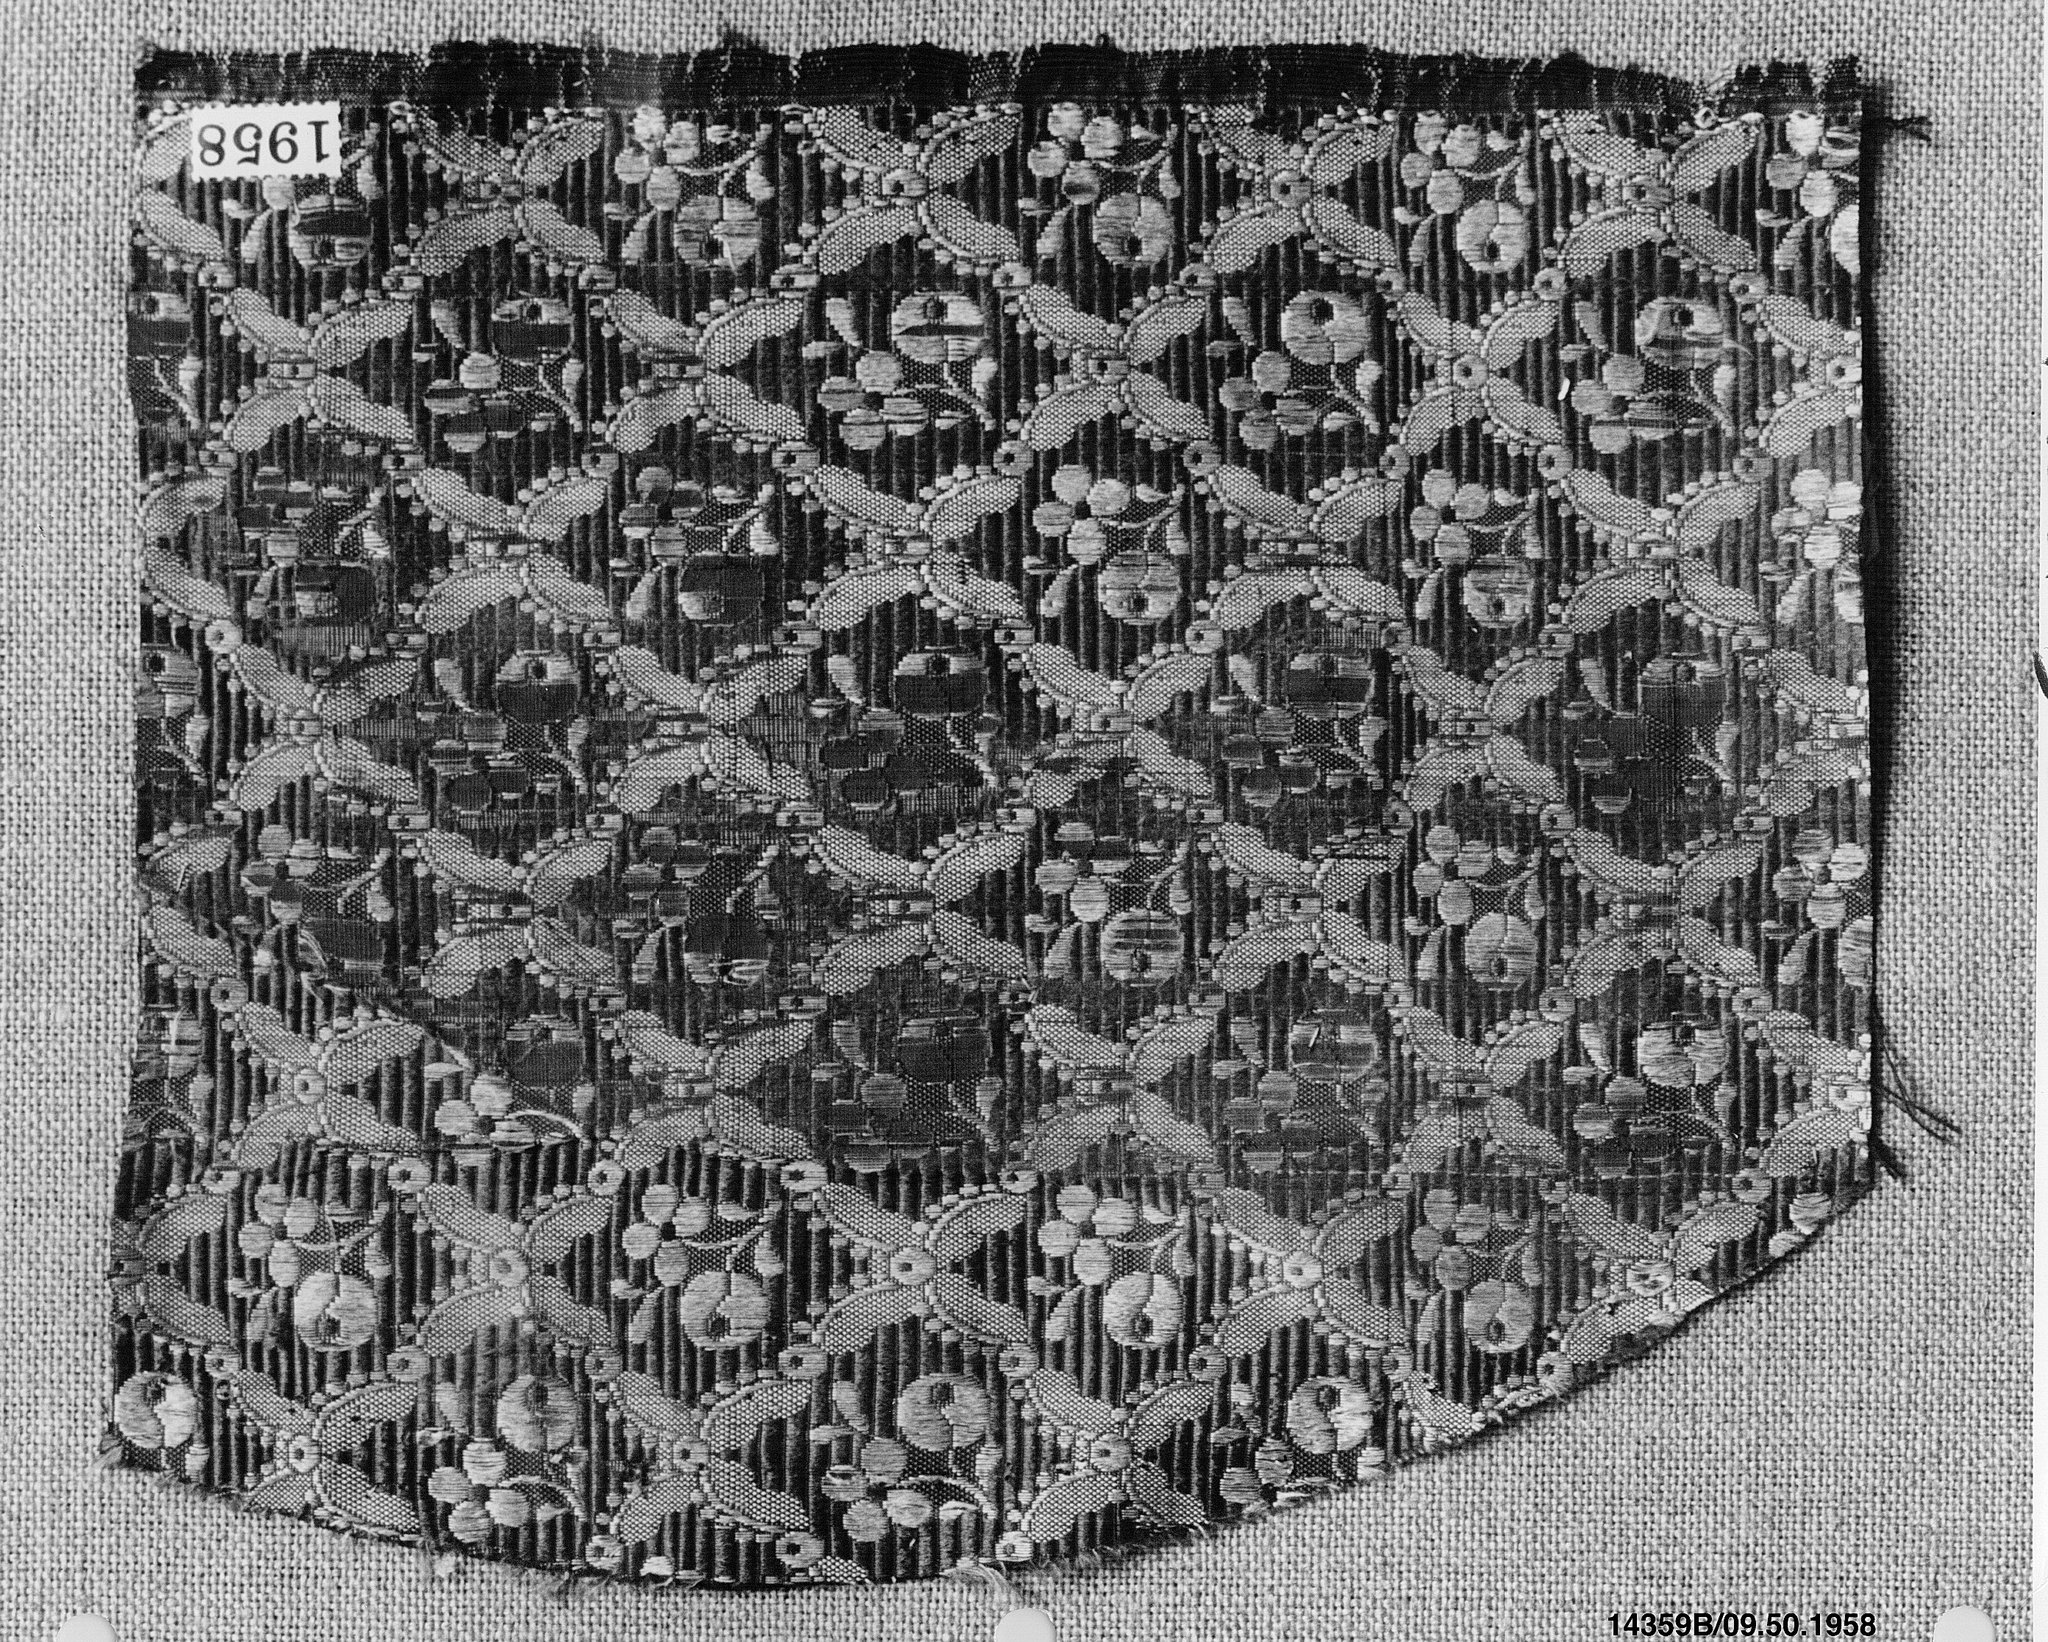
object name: piece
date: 1701-1800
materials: silk